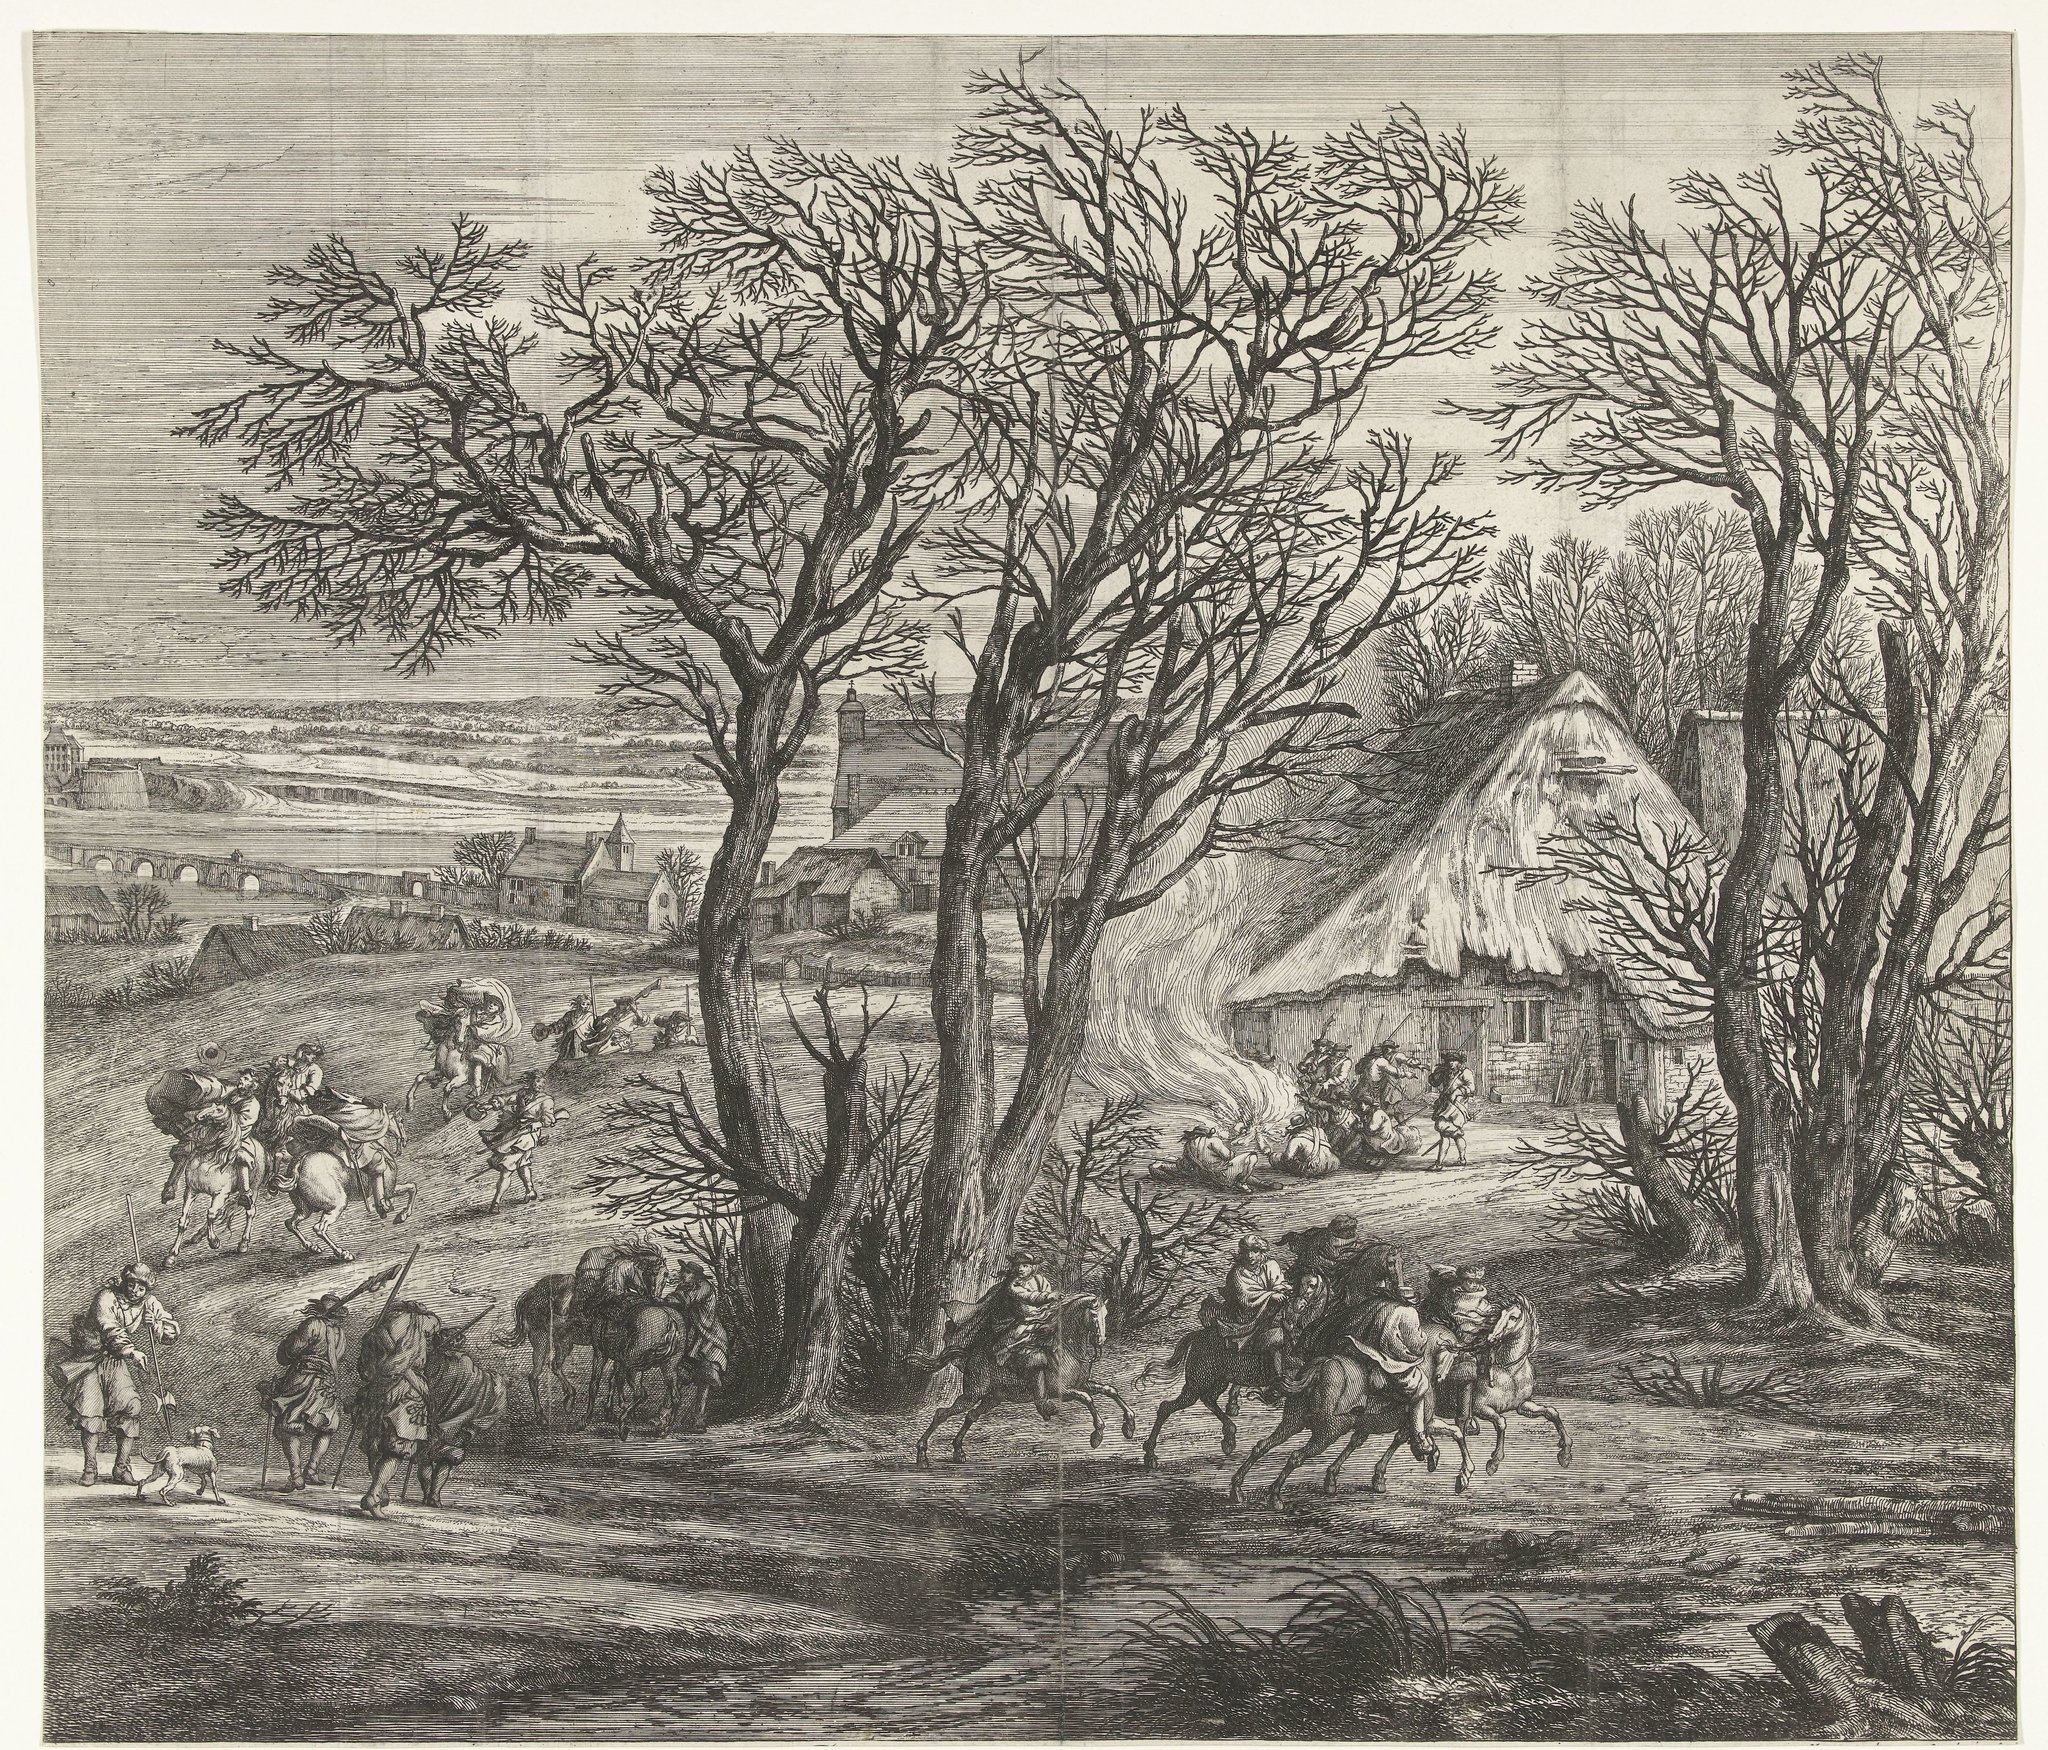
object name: print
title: Het Franse leger voor Yperen (rechterblad), 1678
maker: Anonymous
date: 1678-1699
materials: paper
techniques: engraving, etching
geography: france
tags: lodewijk xiv (koning van frankrijk)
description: Het Franse leger onder koning Lodewijk XIV voor Yperen, op 26 maart 1678 ingenomen. Op de voorgrond officieren te paard en soldaten rond een kampvuur, in de verte Yperen. Rechterblad van een voorstelling in drie bladen.